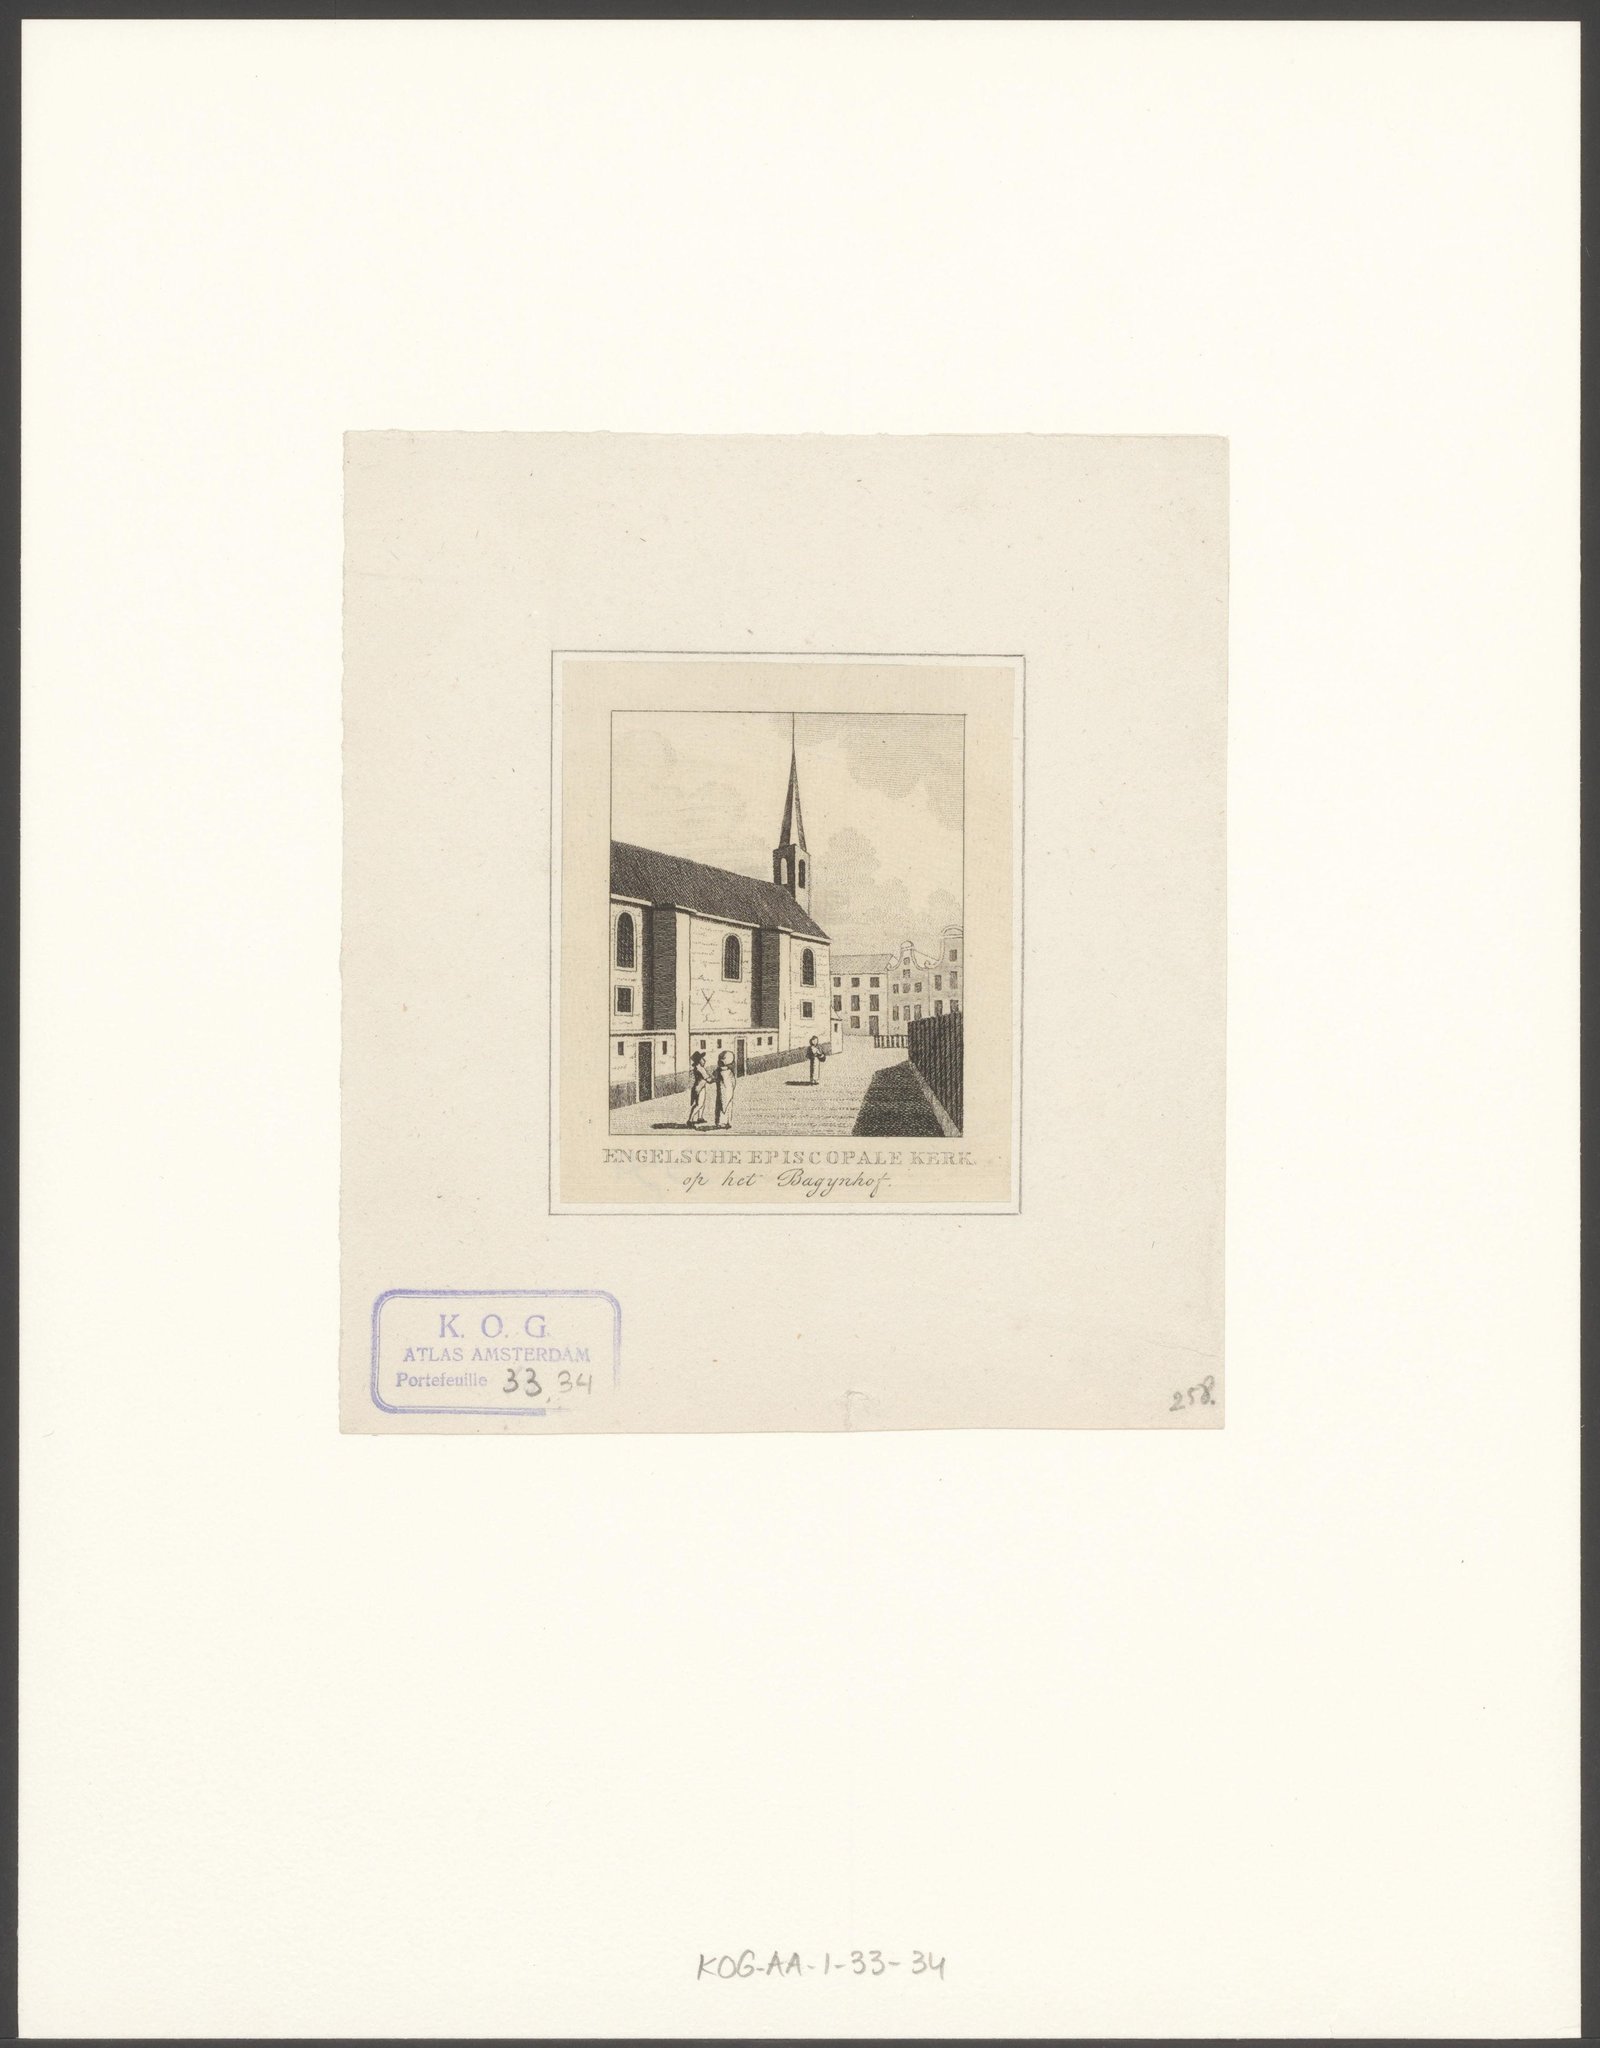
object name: print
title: Gezicht op de Engelse Kerk te Amsterdam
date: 1826-1847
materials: paper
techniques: engraving, etching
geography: amsterdam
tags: church (exterior), street (+ city(-scape) with figures, staffage)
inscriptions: collector's mark: Lugt 1641b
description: Onderwerpsrubriek binnen de Atlas Amsterdam: Kerkwezen: Hervormde Gemeente: Engels Hervormde Gemeente.